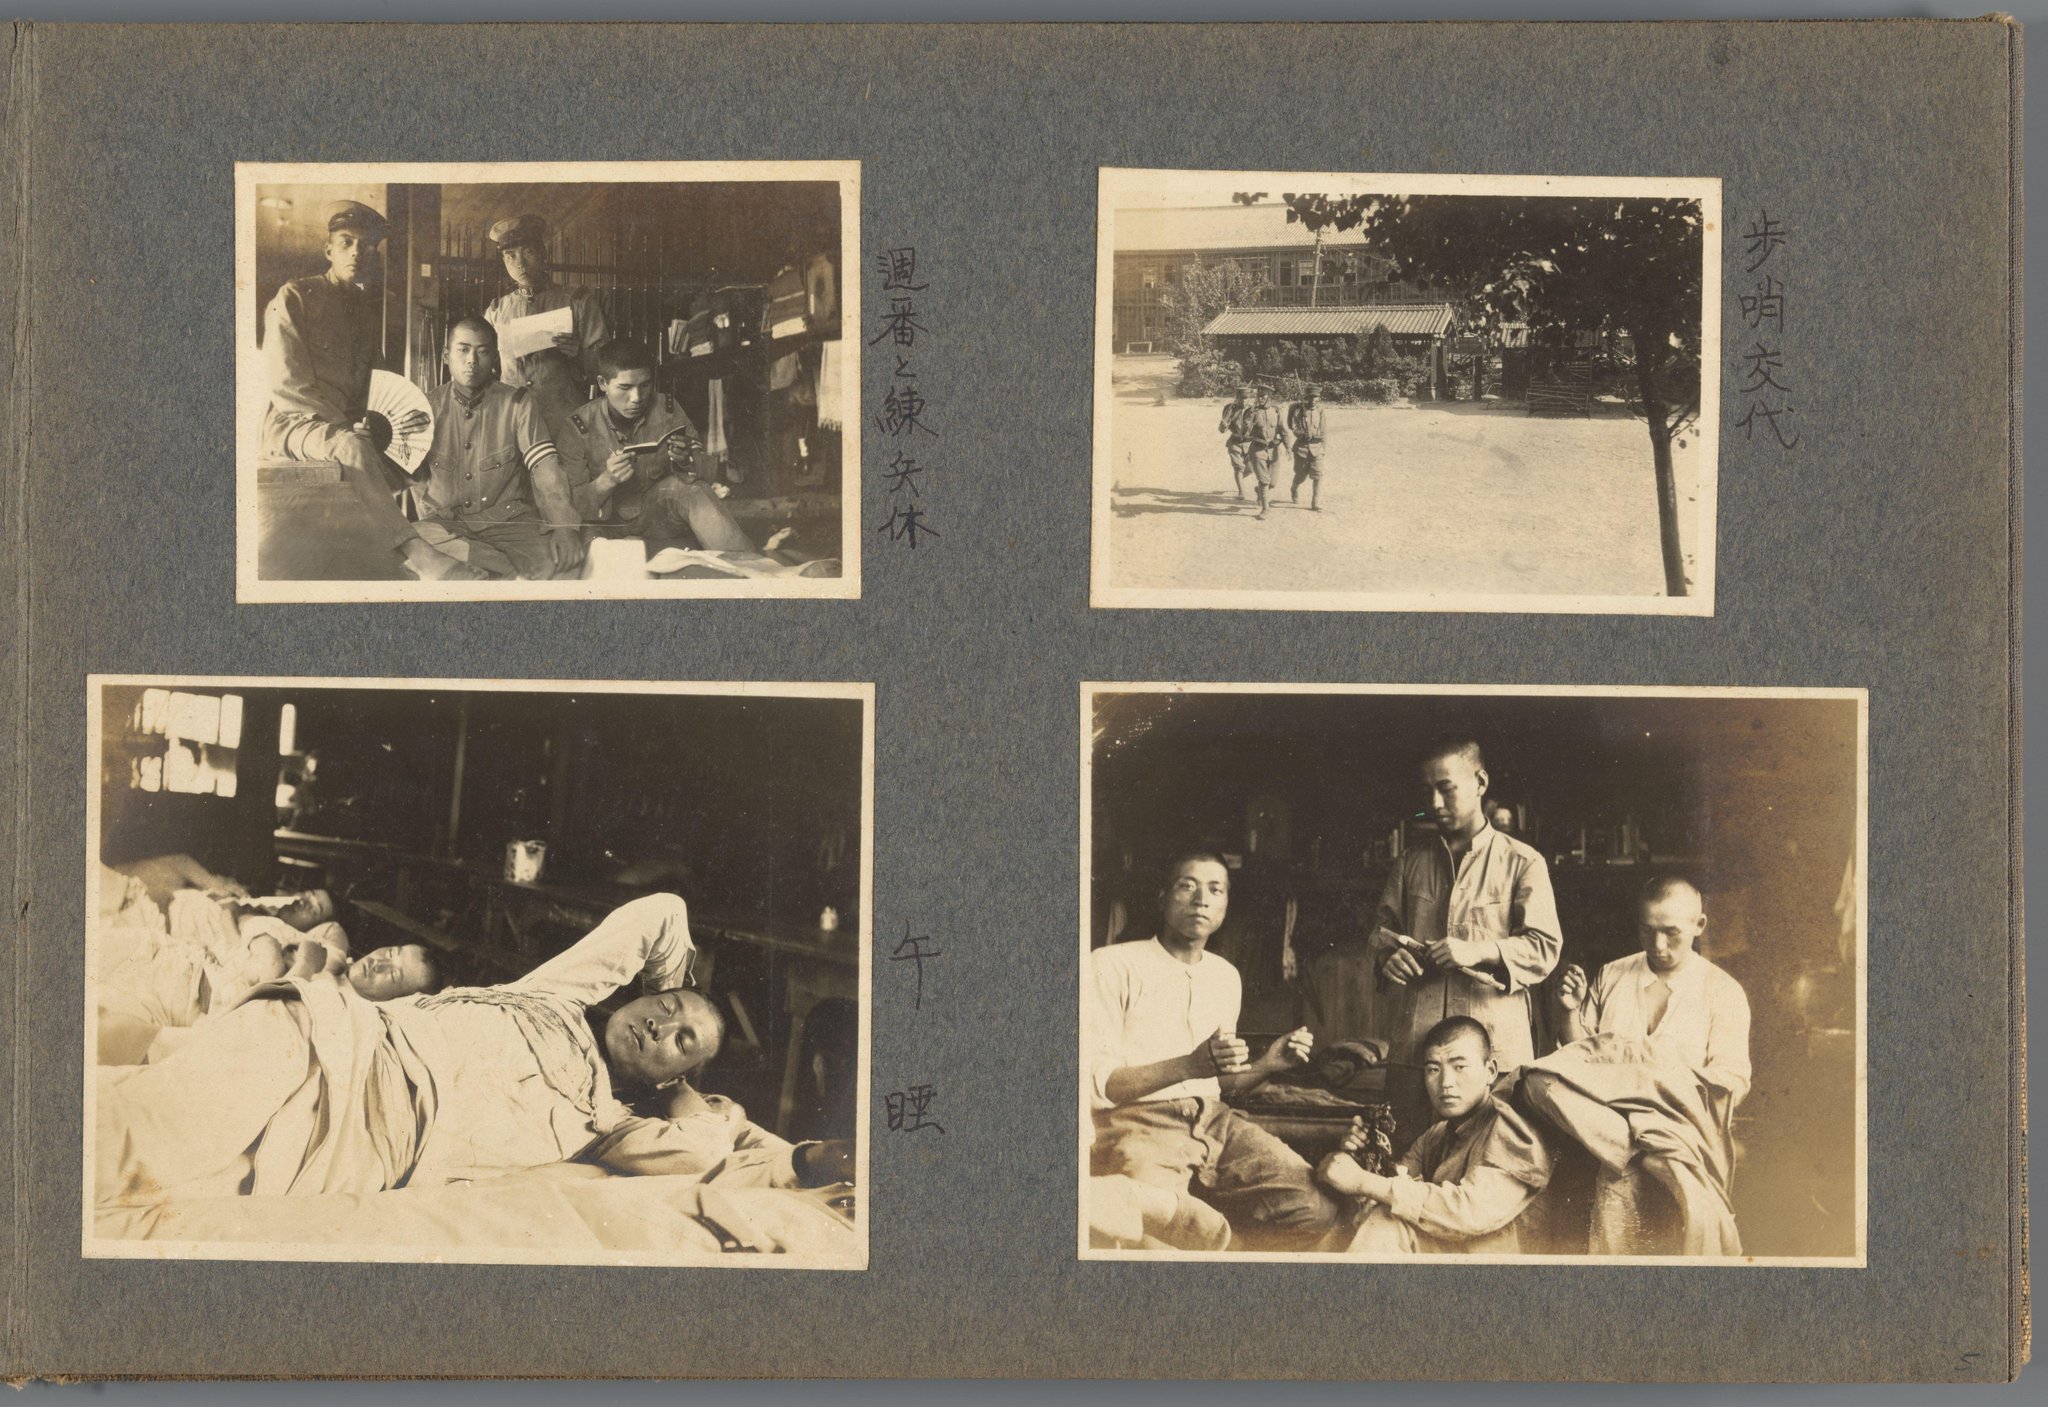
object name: album leaf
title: Medesoldaten in de barak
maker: Anonymous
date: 1930-1940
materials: cardboard, photographic support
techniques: gelatin silver print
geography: japan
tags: military training, japan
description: Albumblad met vier foto's van het leven van Japanse militairen. Bij de foto's opschriften in het Japans. Onderdeel van het leporello fotoalbum met foto’s van de diensttijd van Japanse militairen.